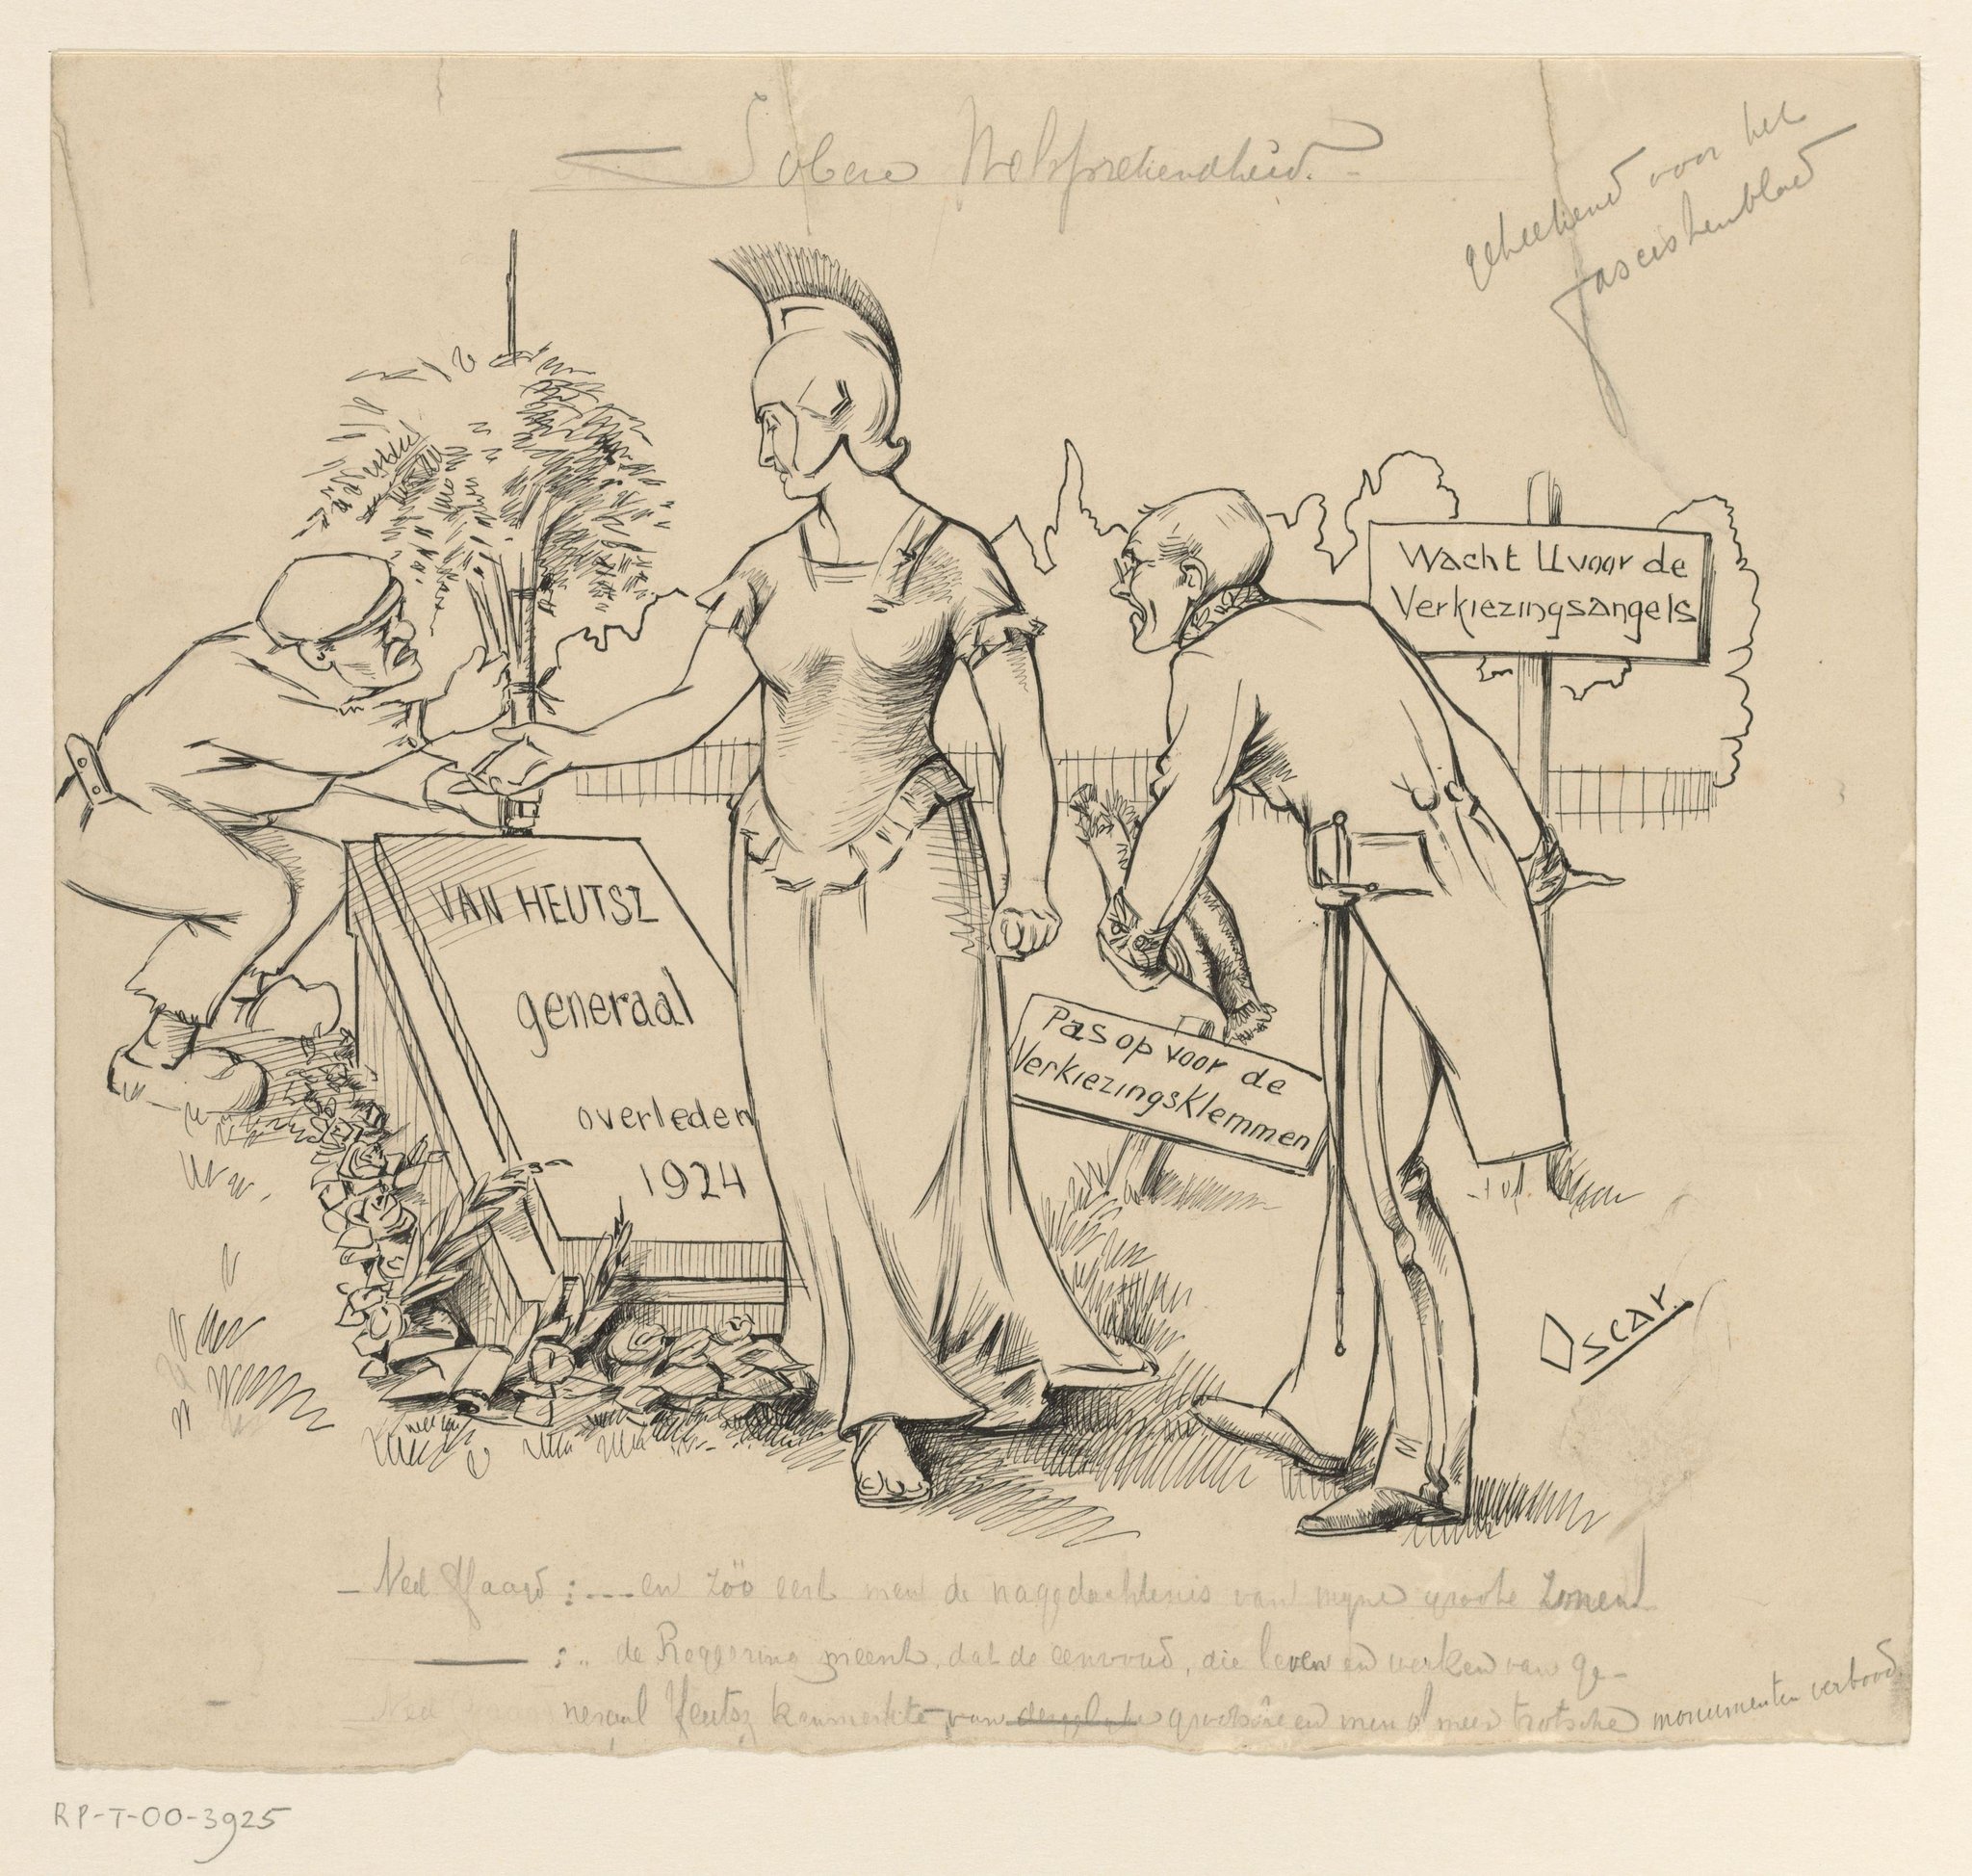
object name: cartoon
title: Sober Welsprekendheid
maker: oscar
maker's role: illustrator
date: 1935-1945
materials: paper, pencil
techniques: brush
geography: netherlands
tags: personifications of countries, nations, states, districts, etc.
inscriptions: collector's mark: Lugt 2228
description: Ontwerptekening voor een politieke spotprent. De Nederlandse Maagd staande bij een zeer eenvoudige grafsteen voor generaal Van Heutsz, overleden op 11 juli 1924. Links plaatst een man een boeket bij het graf, rechts een buigende minister. Met drieregelig onderschrift. Mogelijk naar aanleiding van de onthulling in 1935 of commotie rond het monument tijdens de oorlog. Rechtsboven het opschrift 'geteekend voor het fascistenblad'.